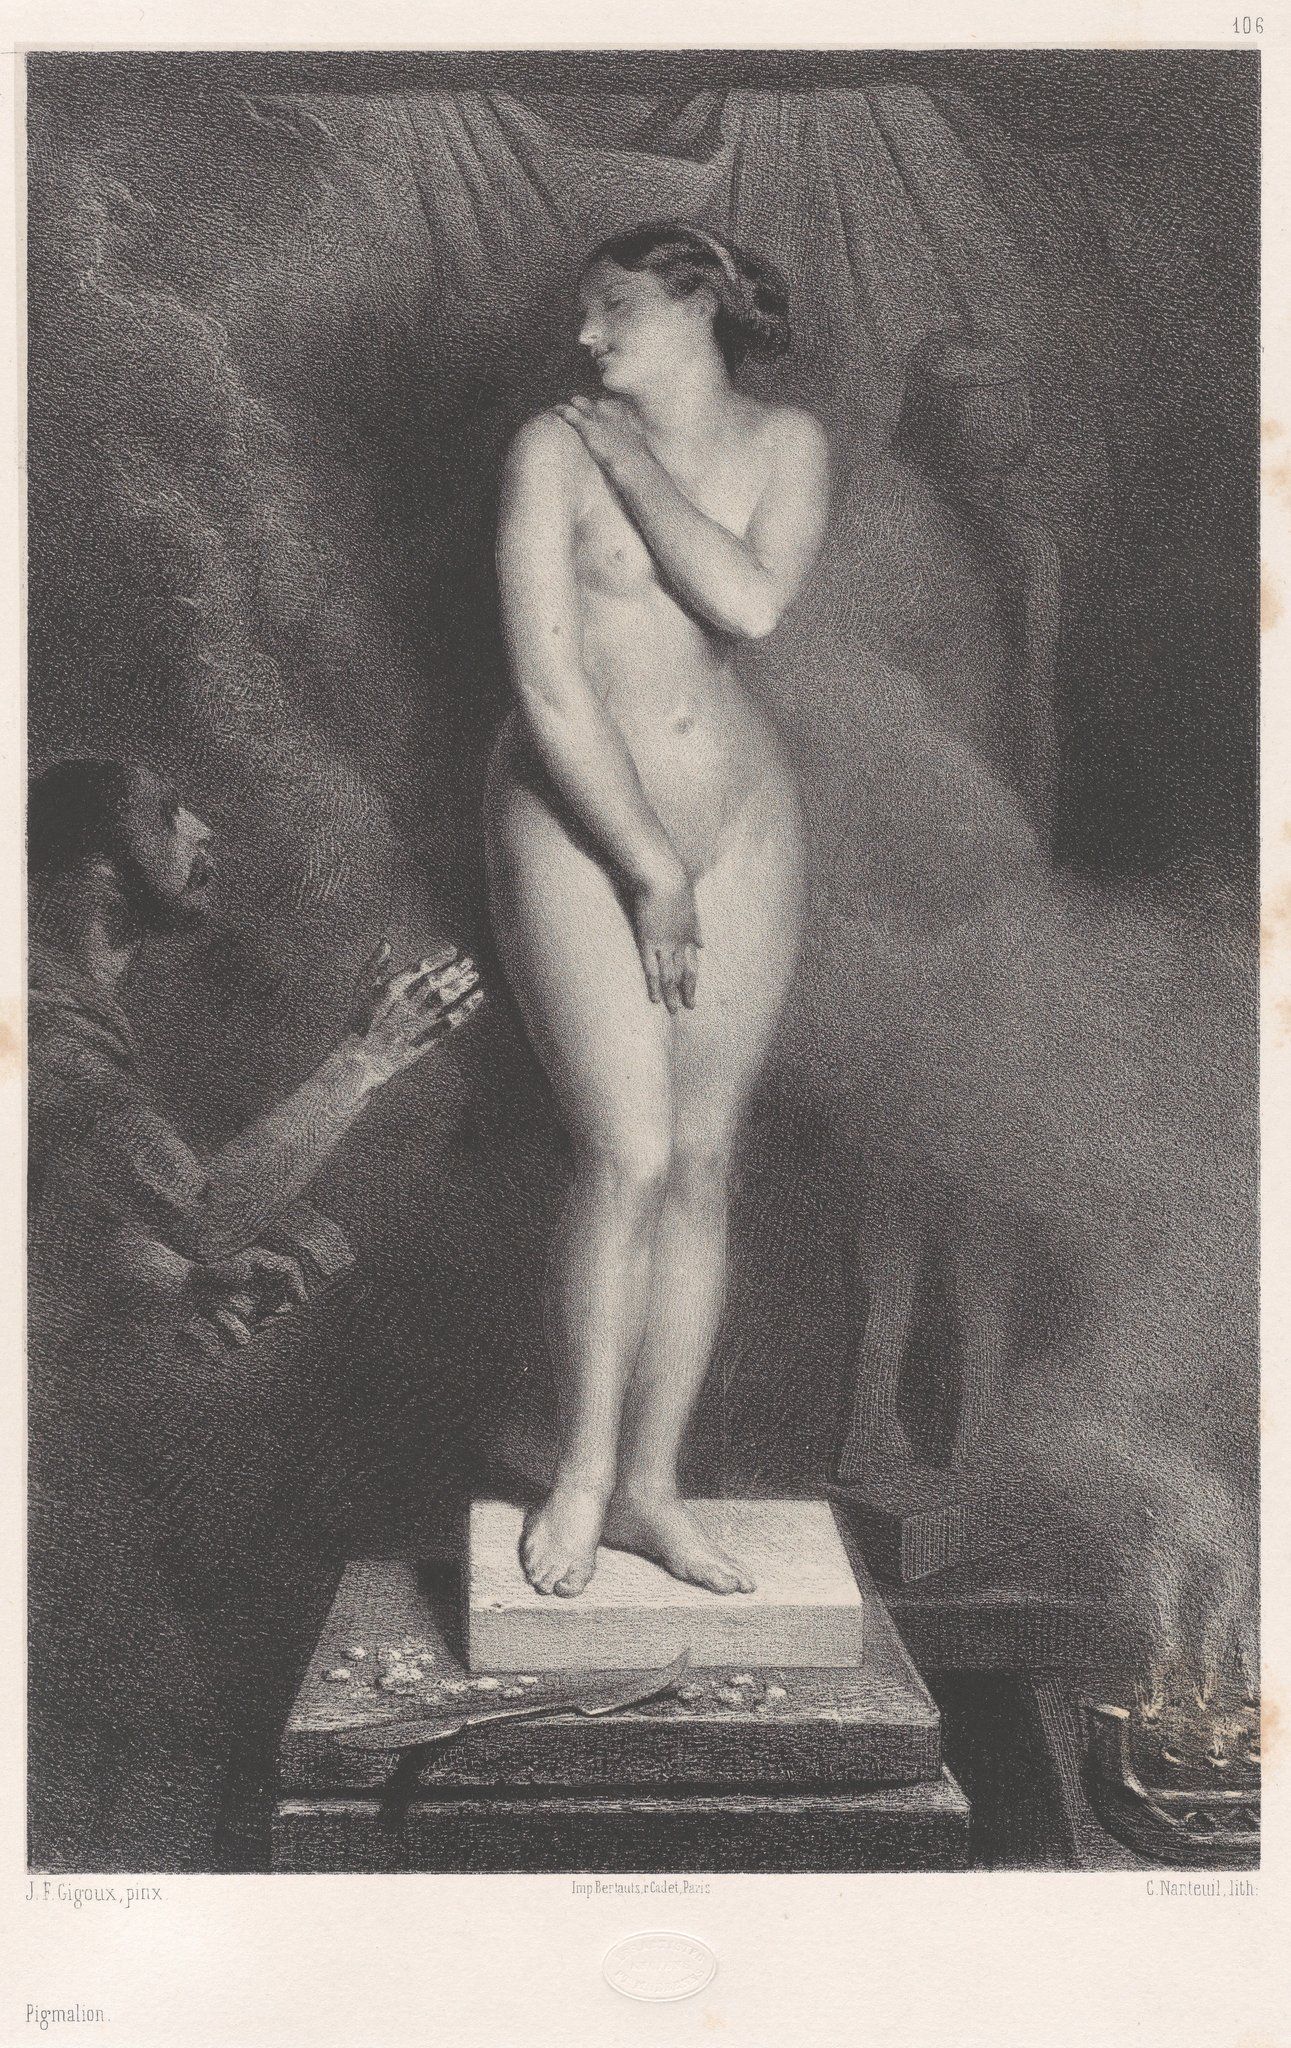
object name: print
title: Pygmalion and Galatea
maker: jean-françois gigoux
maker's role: print maker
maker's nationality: french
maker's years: 1806-1894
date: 1852-1862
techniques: lithograph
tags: men,female nudes,galatea,pygmalion